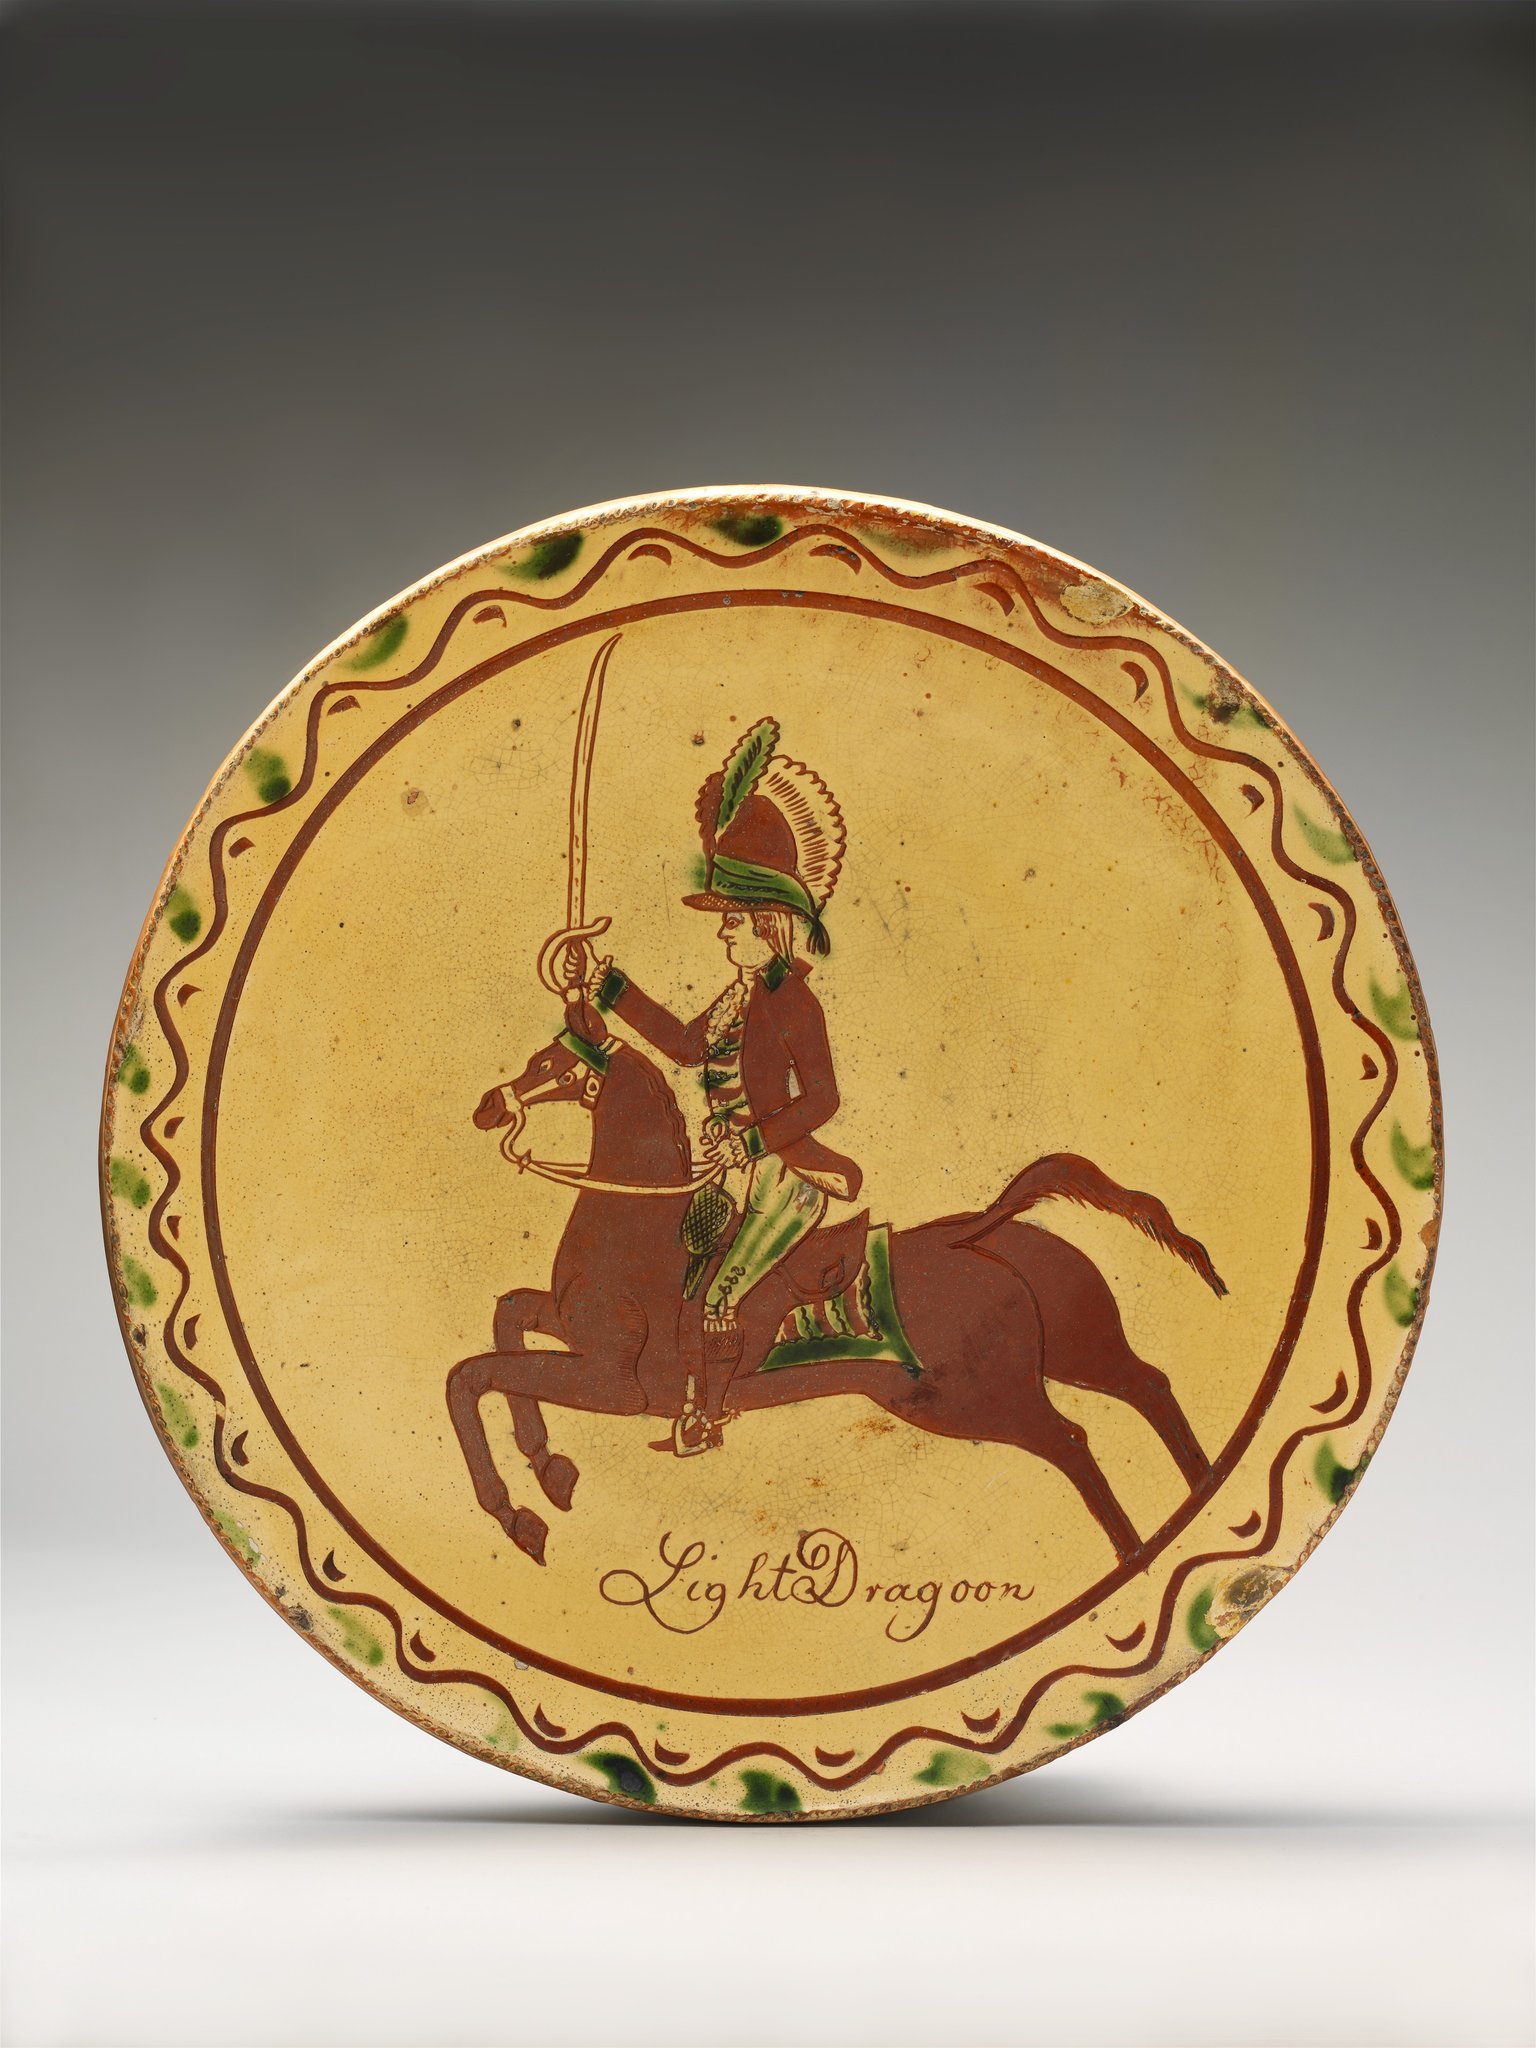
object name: plate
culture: american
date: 1820-1850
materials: earthenware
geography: united states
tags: swords,men,horses